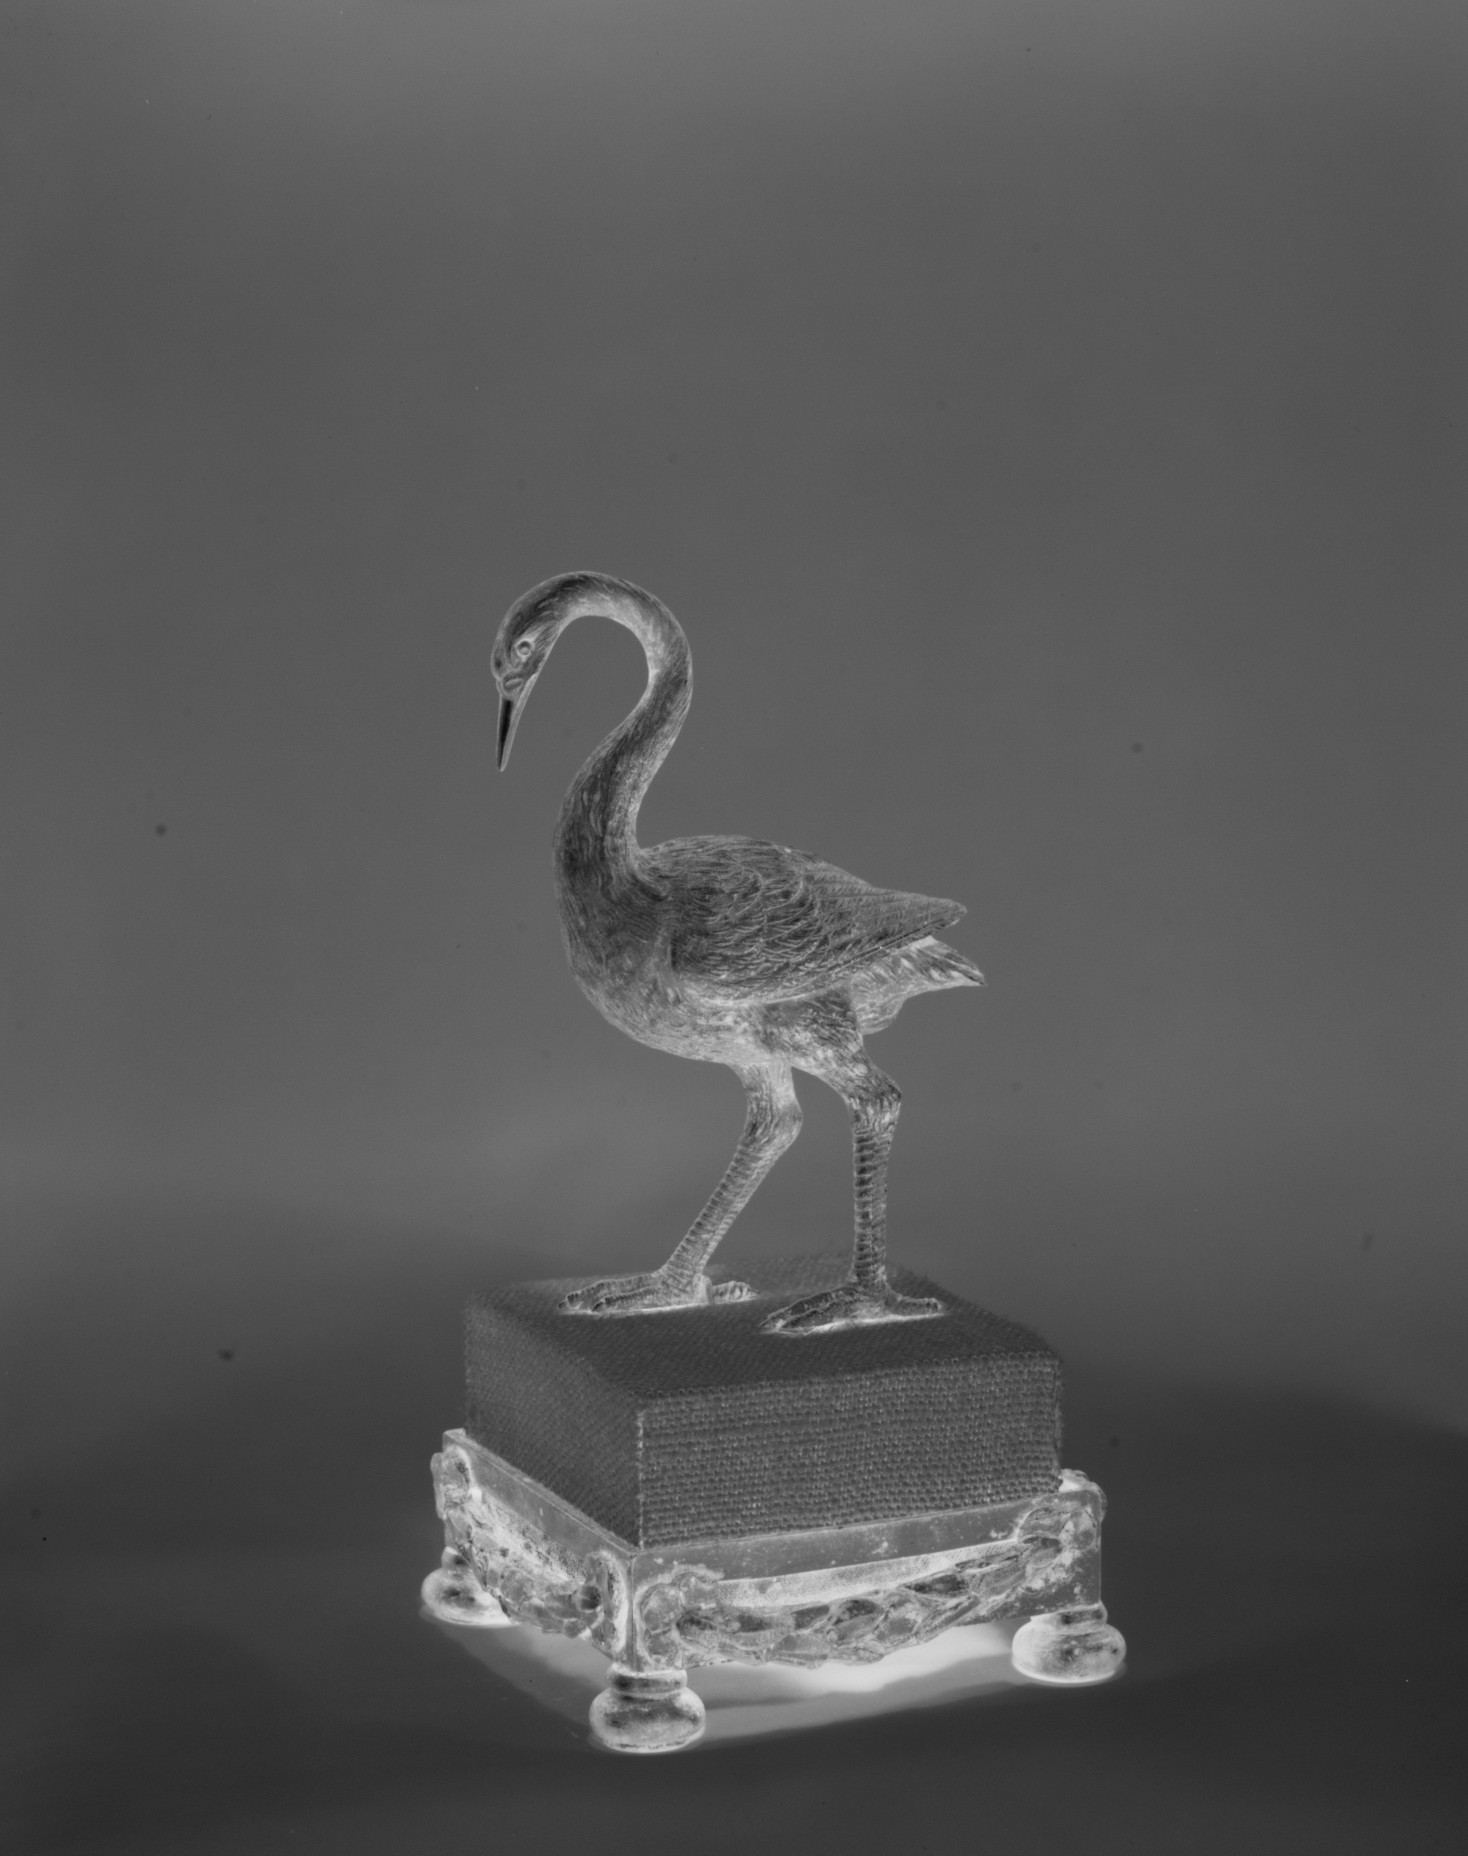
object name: ornament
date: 1701-1800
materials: gilt bronze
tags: swans